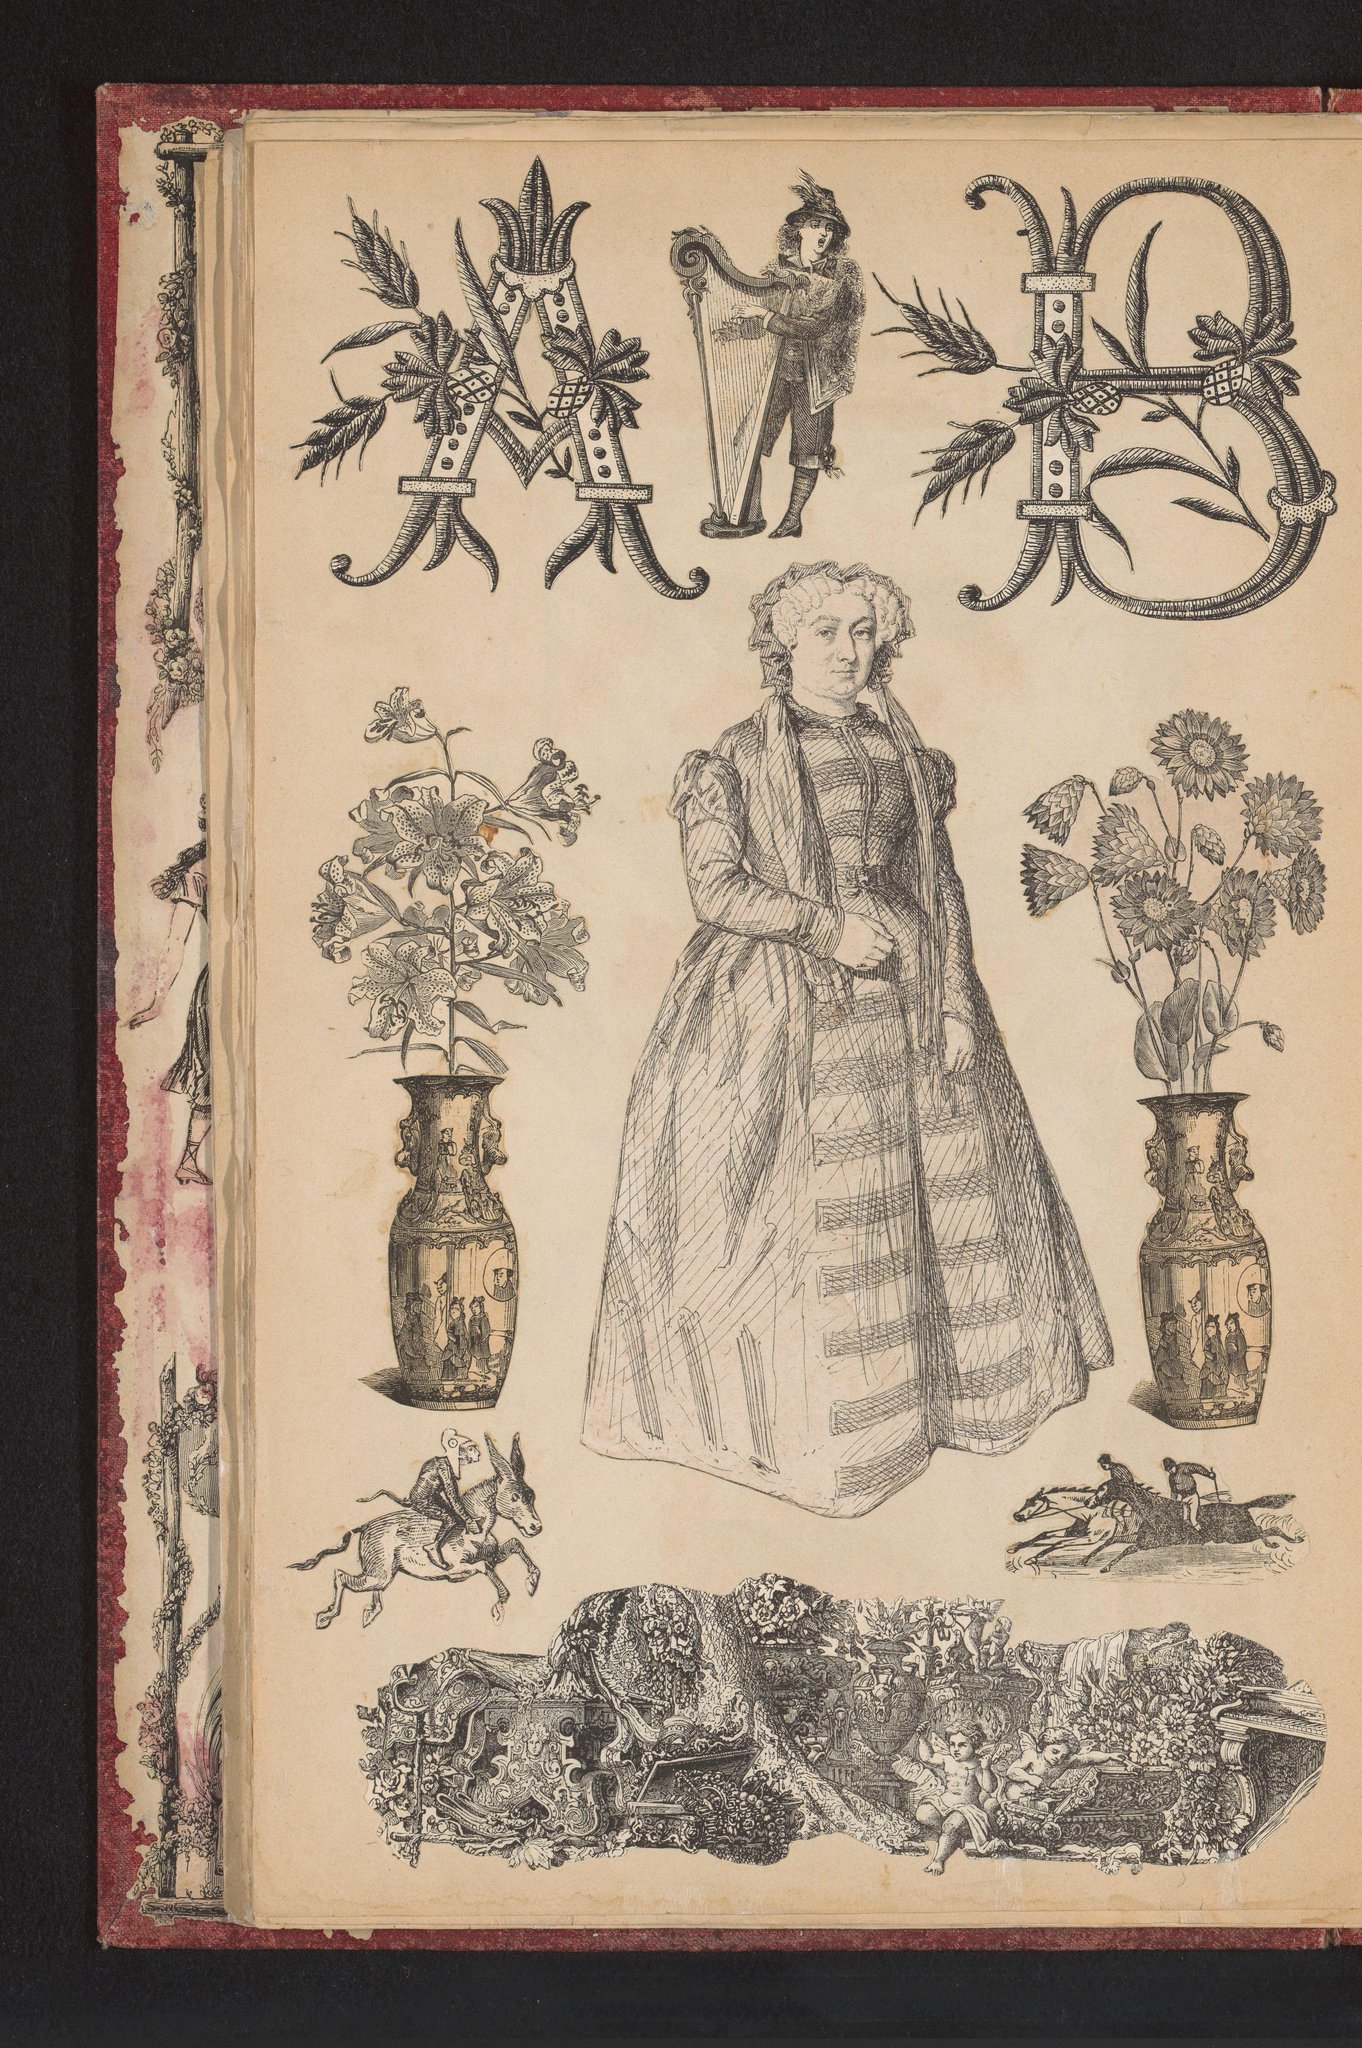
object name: collage visual work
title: Collage van uitgeknipte prenten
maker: Anonymous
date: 1870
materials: paper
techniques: engraving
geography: paris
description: Collage van uitgeknipte prenten. Onderdeel van een album met 32 bladen, aan beide zijden beplakt met uitgeknipte prenten, vermoedelijk afkomstig uit 19e-eeuwse tijdschiften.